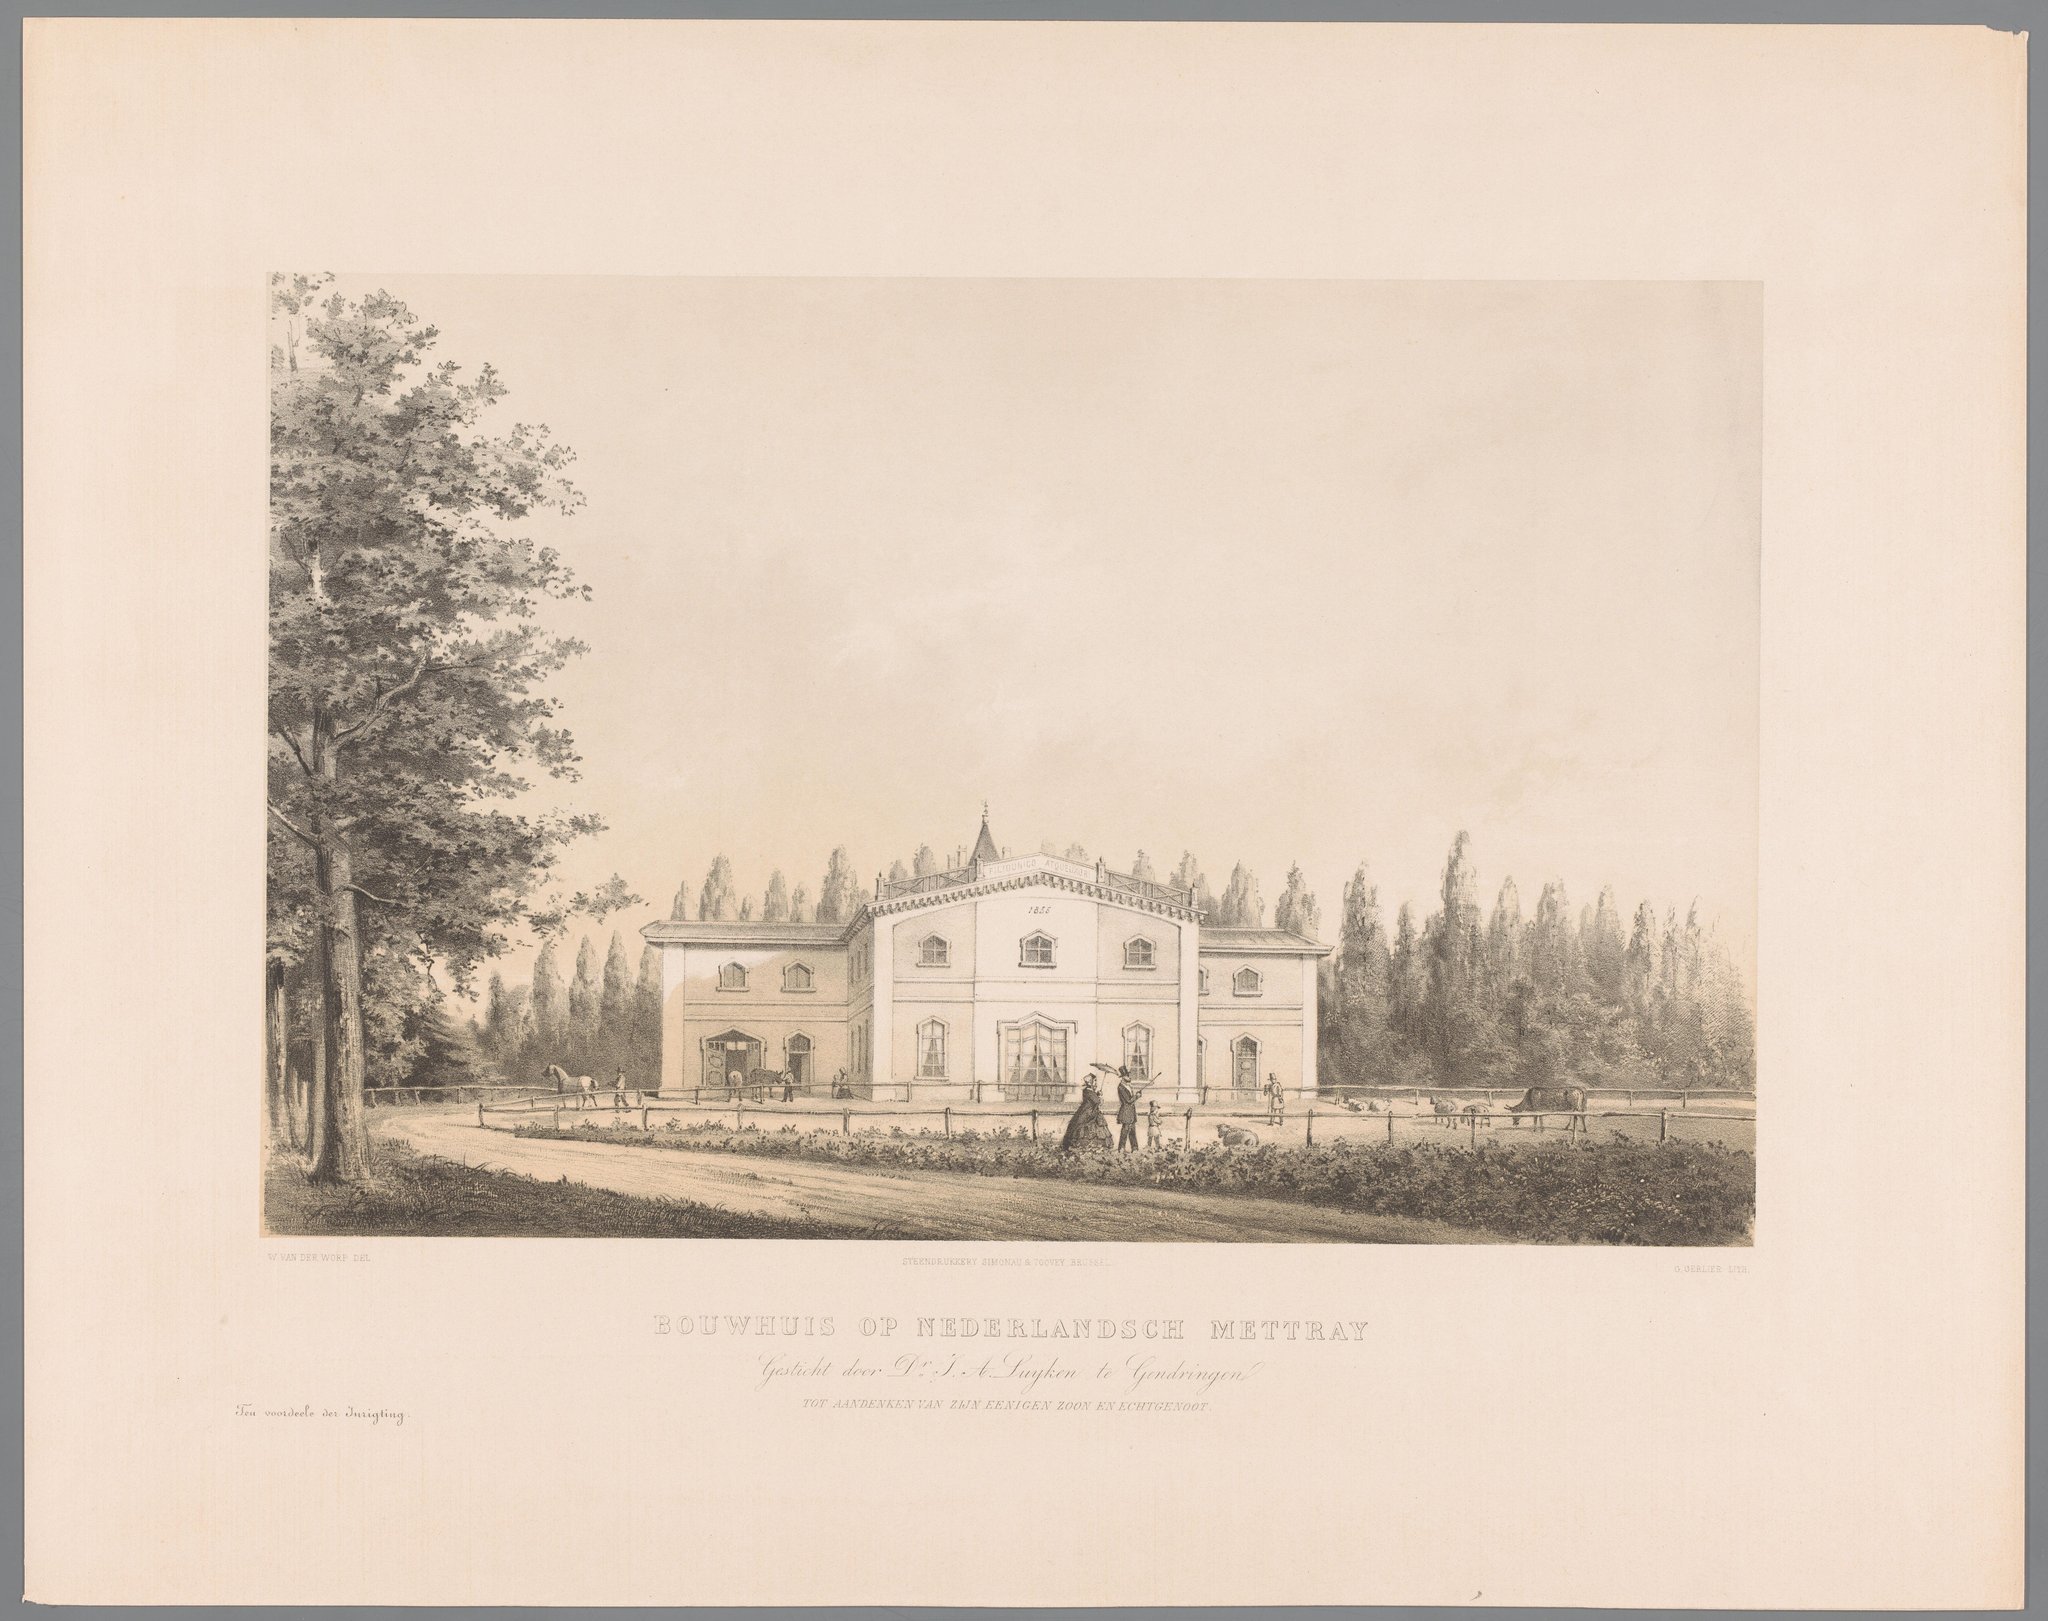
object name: print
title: Bouwhuis op Nederlandsch Mettray gesticht door Dr. J.A. Luyken te Gendringen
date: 1855-1870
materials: paper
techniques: iris print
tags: cattle, civic architecture; edifices; dwellings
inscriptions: collector's mark: Lugt 2228